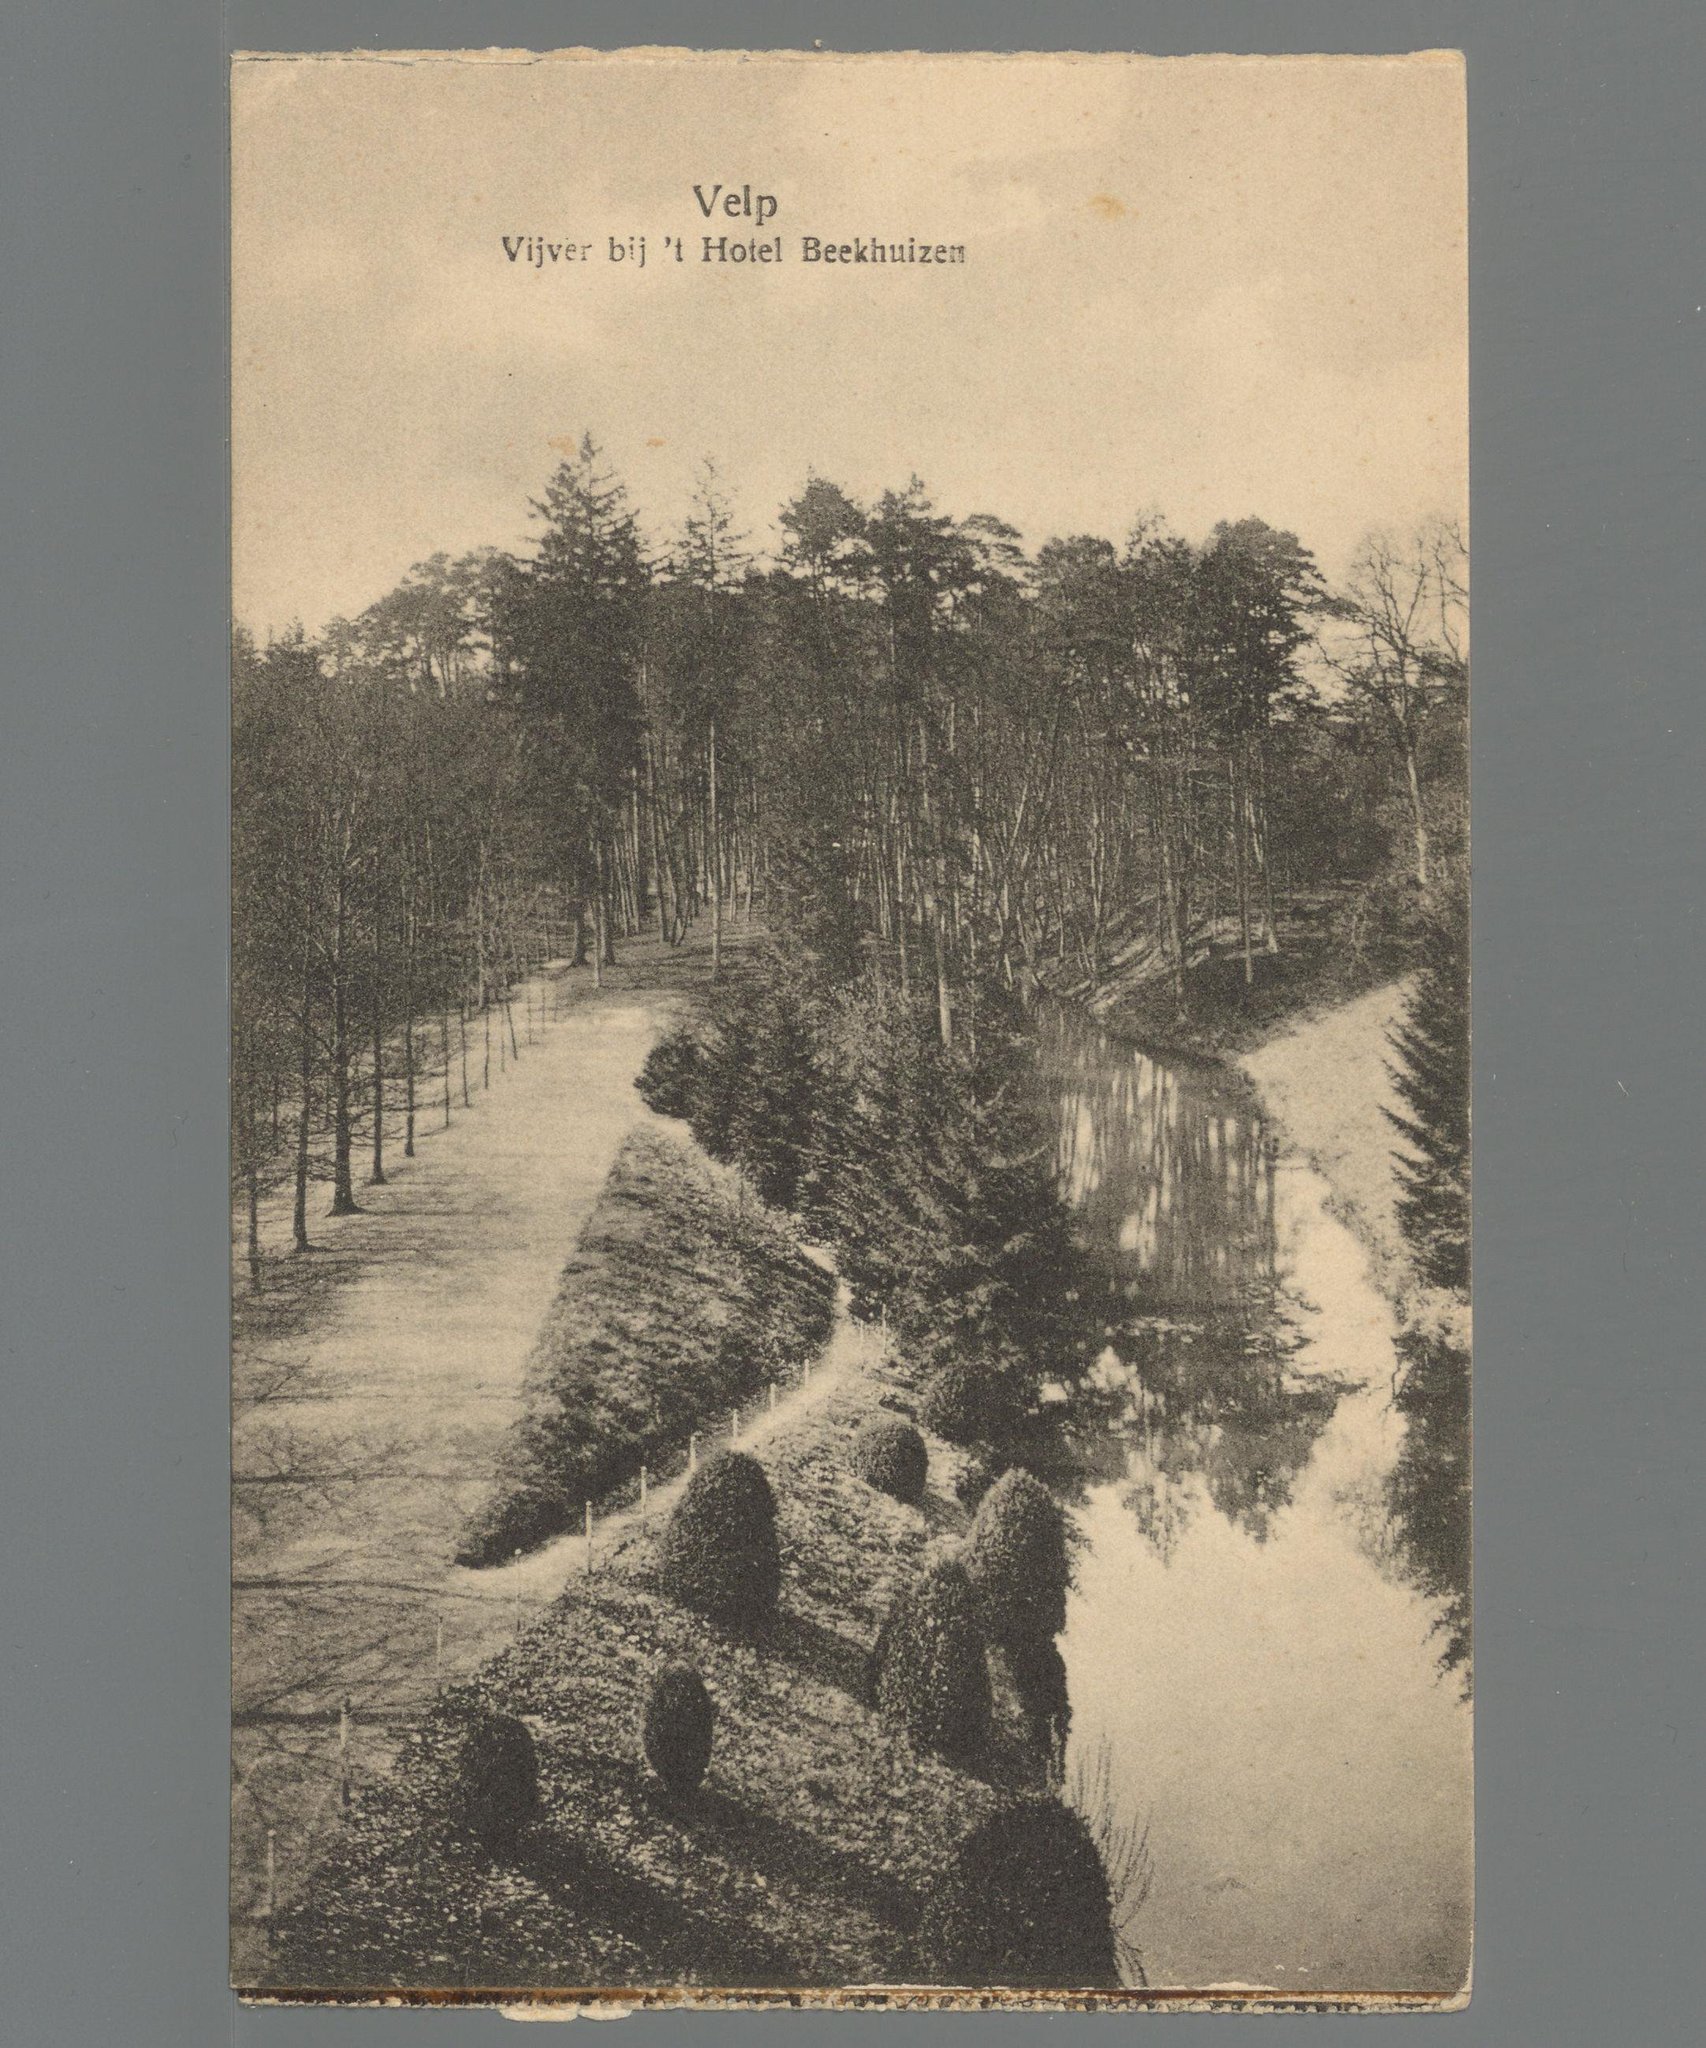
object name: photomechanical print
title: Velp. Vijver bij 't Hotel Beekhuizen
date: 1922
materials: cardboard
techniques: photograph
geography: velp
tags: forest, wood, pond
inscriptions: date